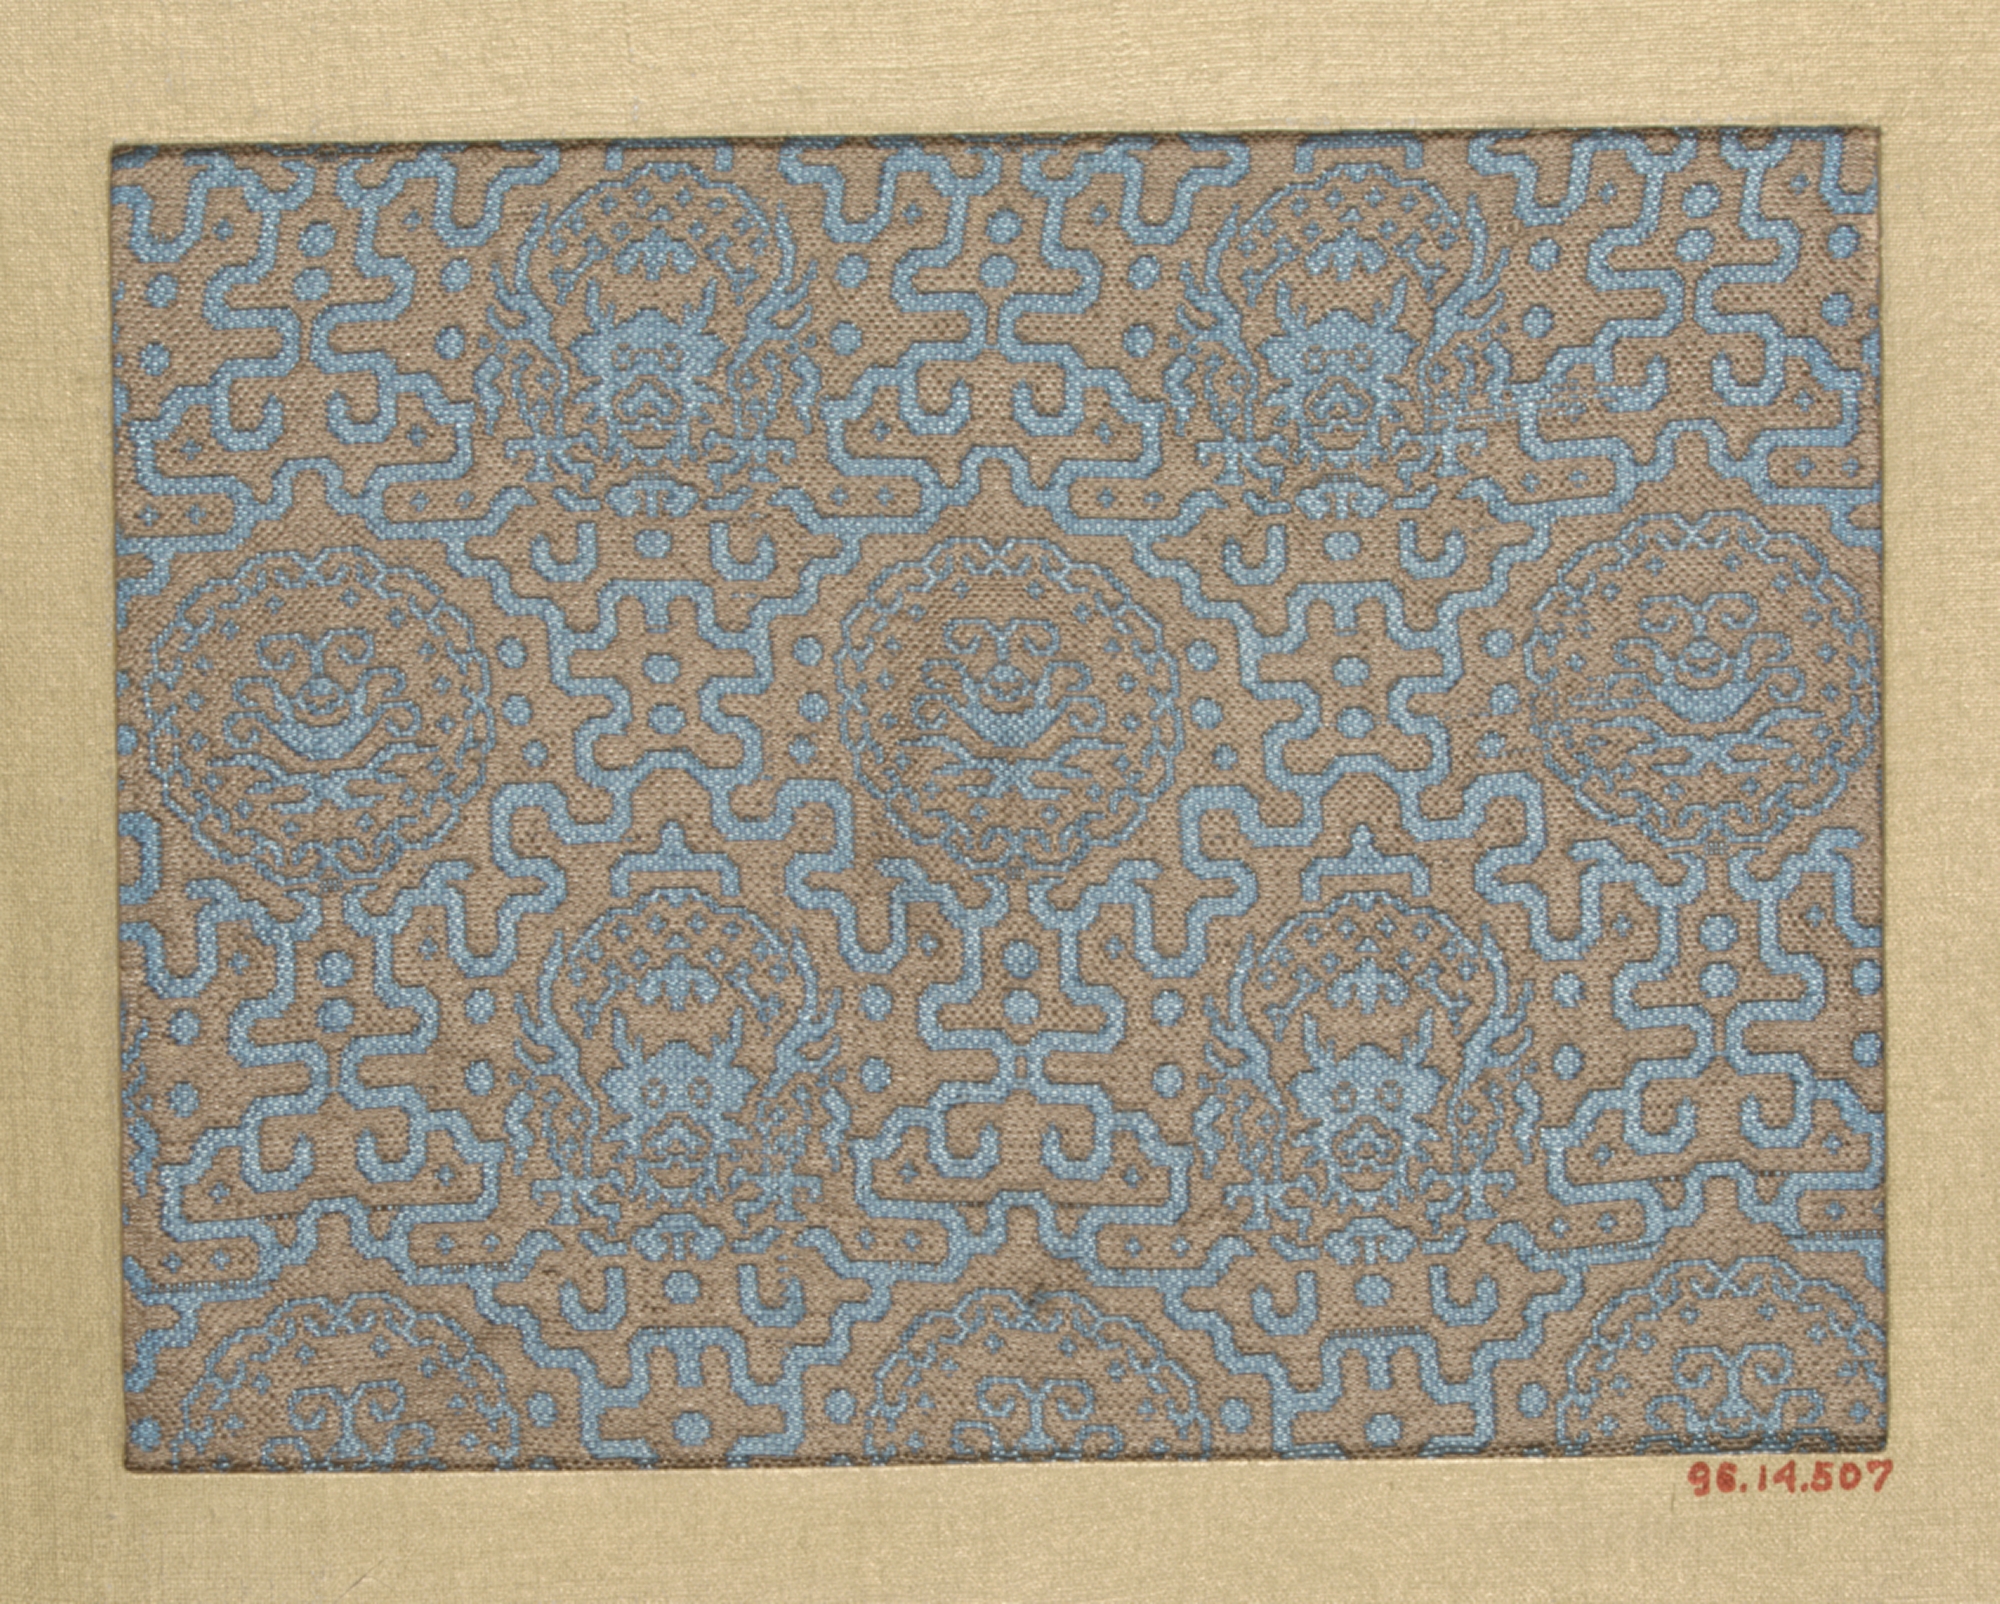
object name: piece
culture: japanese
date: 1701-1900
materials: silk